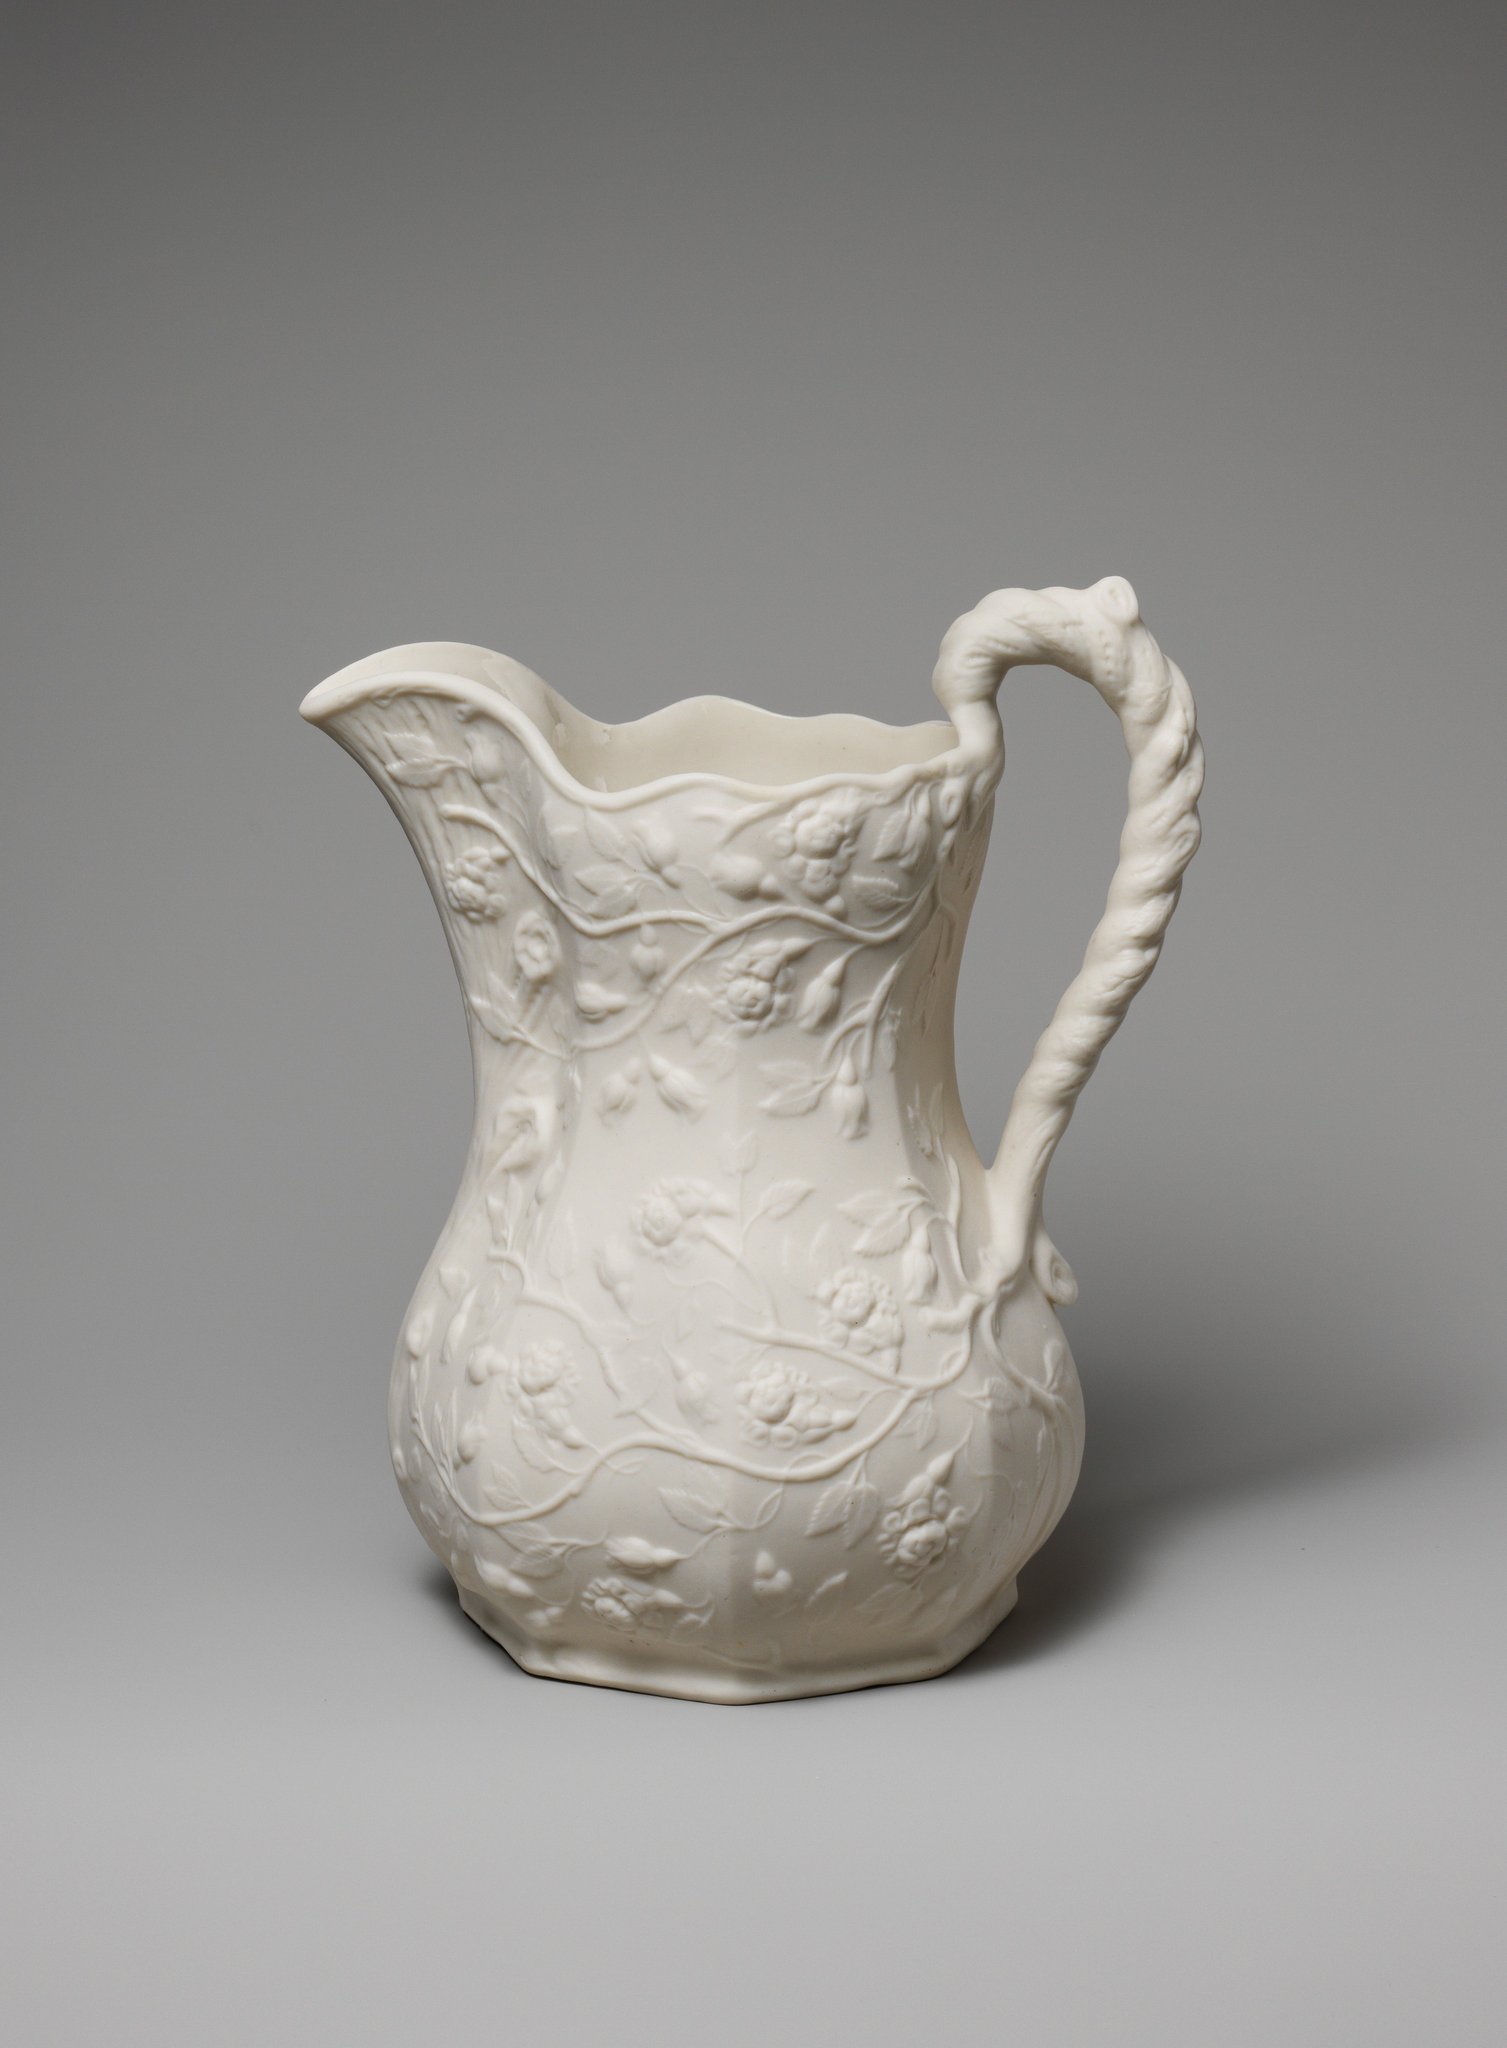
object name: pitcher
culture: american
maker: fenton's works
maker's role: maker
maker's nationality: american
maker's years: 1847-1848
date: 1847-1853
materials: porcelain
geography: united states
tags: flowers